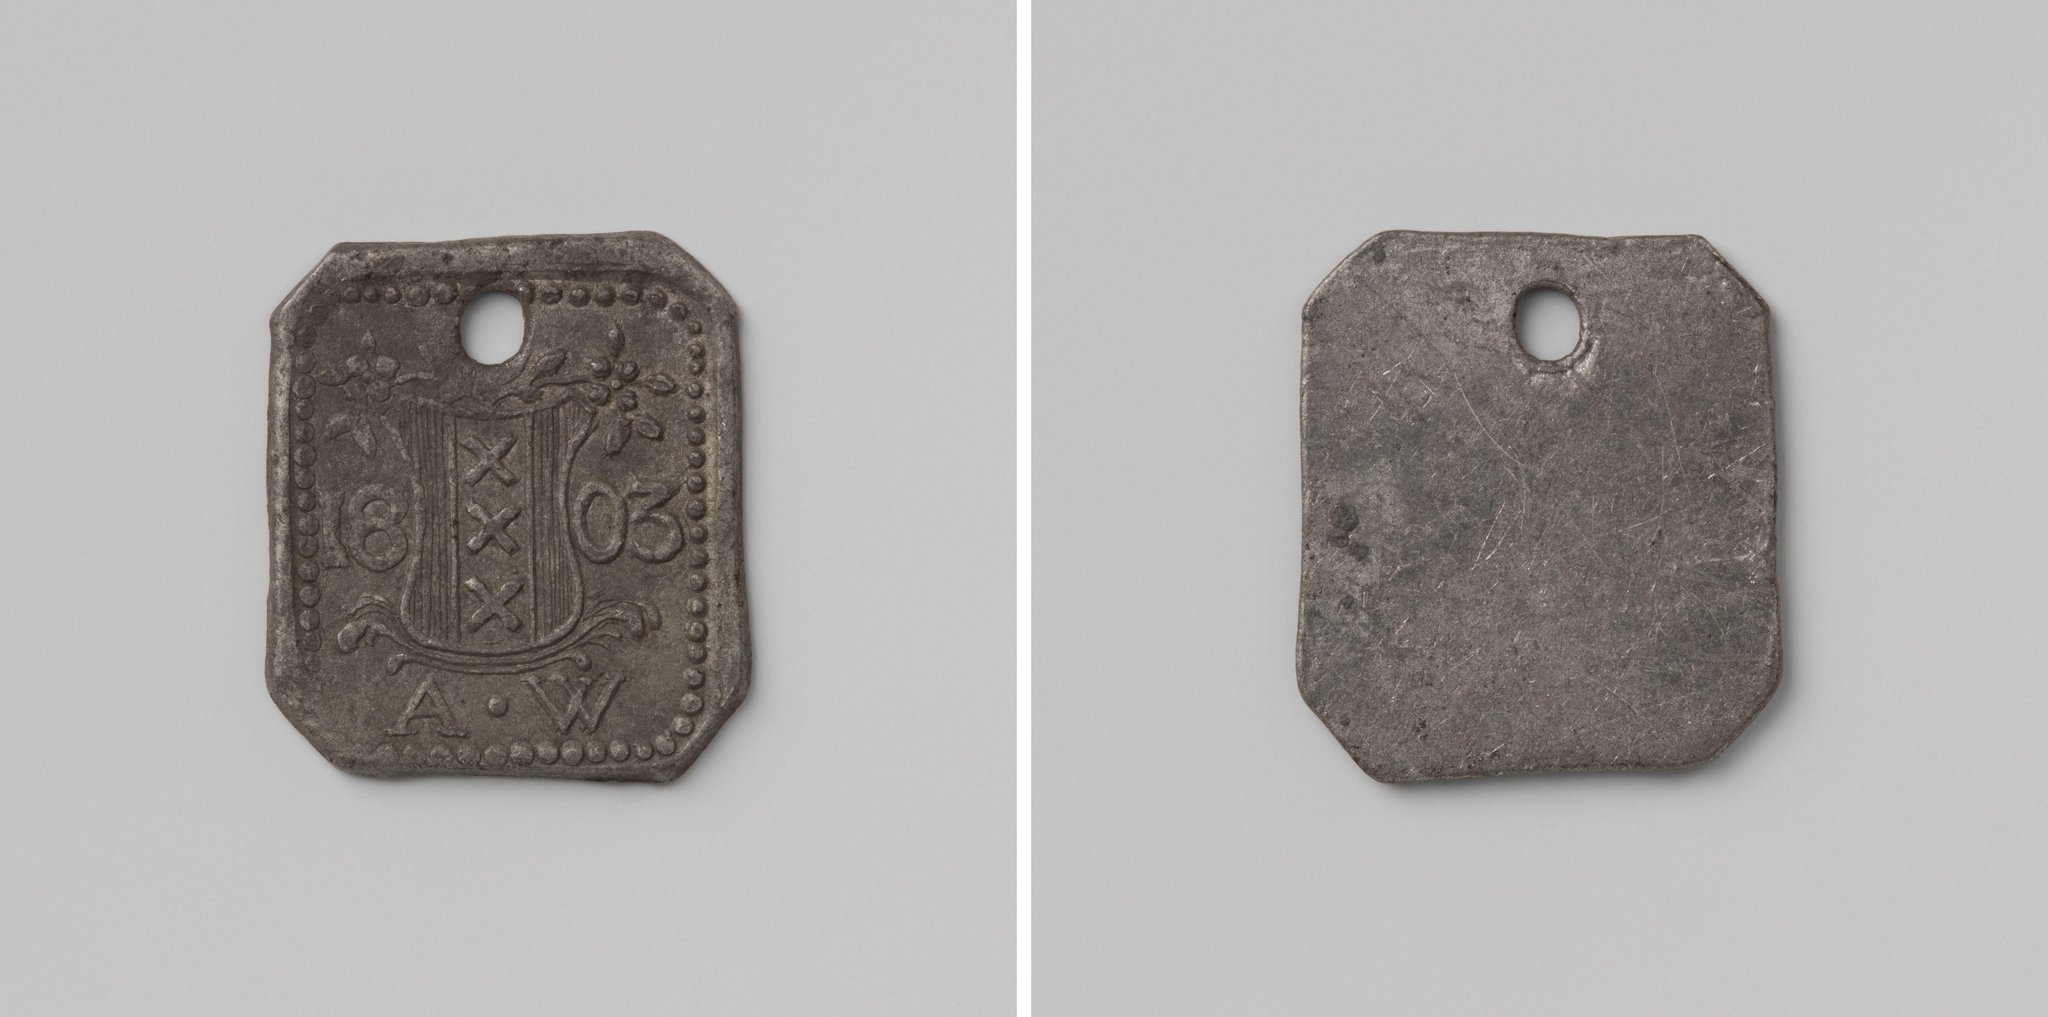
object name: tax token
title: Aalmoezeniersweeshuis te Amsterdam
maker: Anonymous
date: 1803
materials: tin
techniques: striking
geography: amsterdam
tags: amsterdam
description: eenzijdig, rechthoekig loodje met gat erin. Voorzijde: wapenschild, omgeven door bladertakjes tussen jaartal boven opschrift AW. Keerzijde: blanco